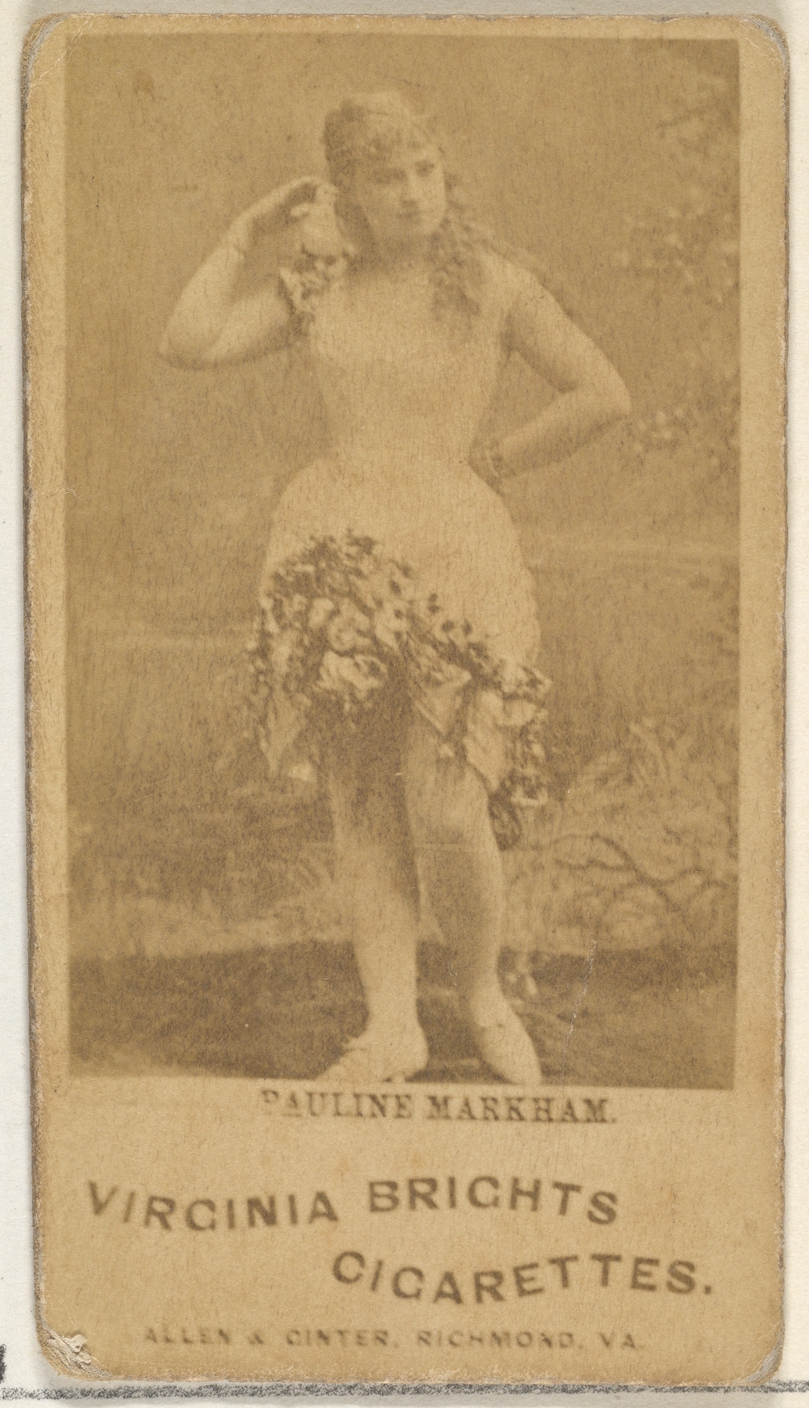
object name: photograph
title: Pauline Markham, from the Actors and Actresses series (N45, Type 1) for Virginia Brights Cigarettes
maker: allen & ginter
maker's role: publisher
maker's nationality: american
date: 1888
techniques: albumen silver print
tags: portraits,women,actresses